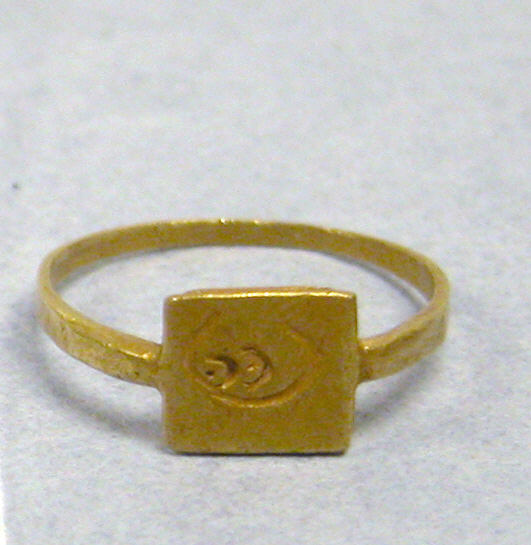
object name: ring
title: Engraved Ring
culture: indonesian, central java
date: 701-1200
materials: gold